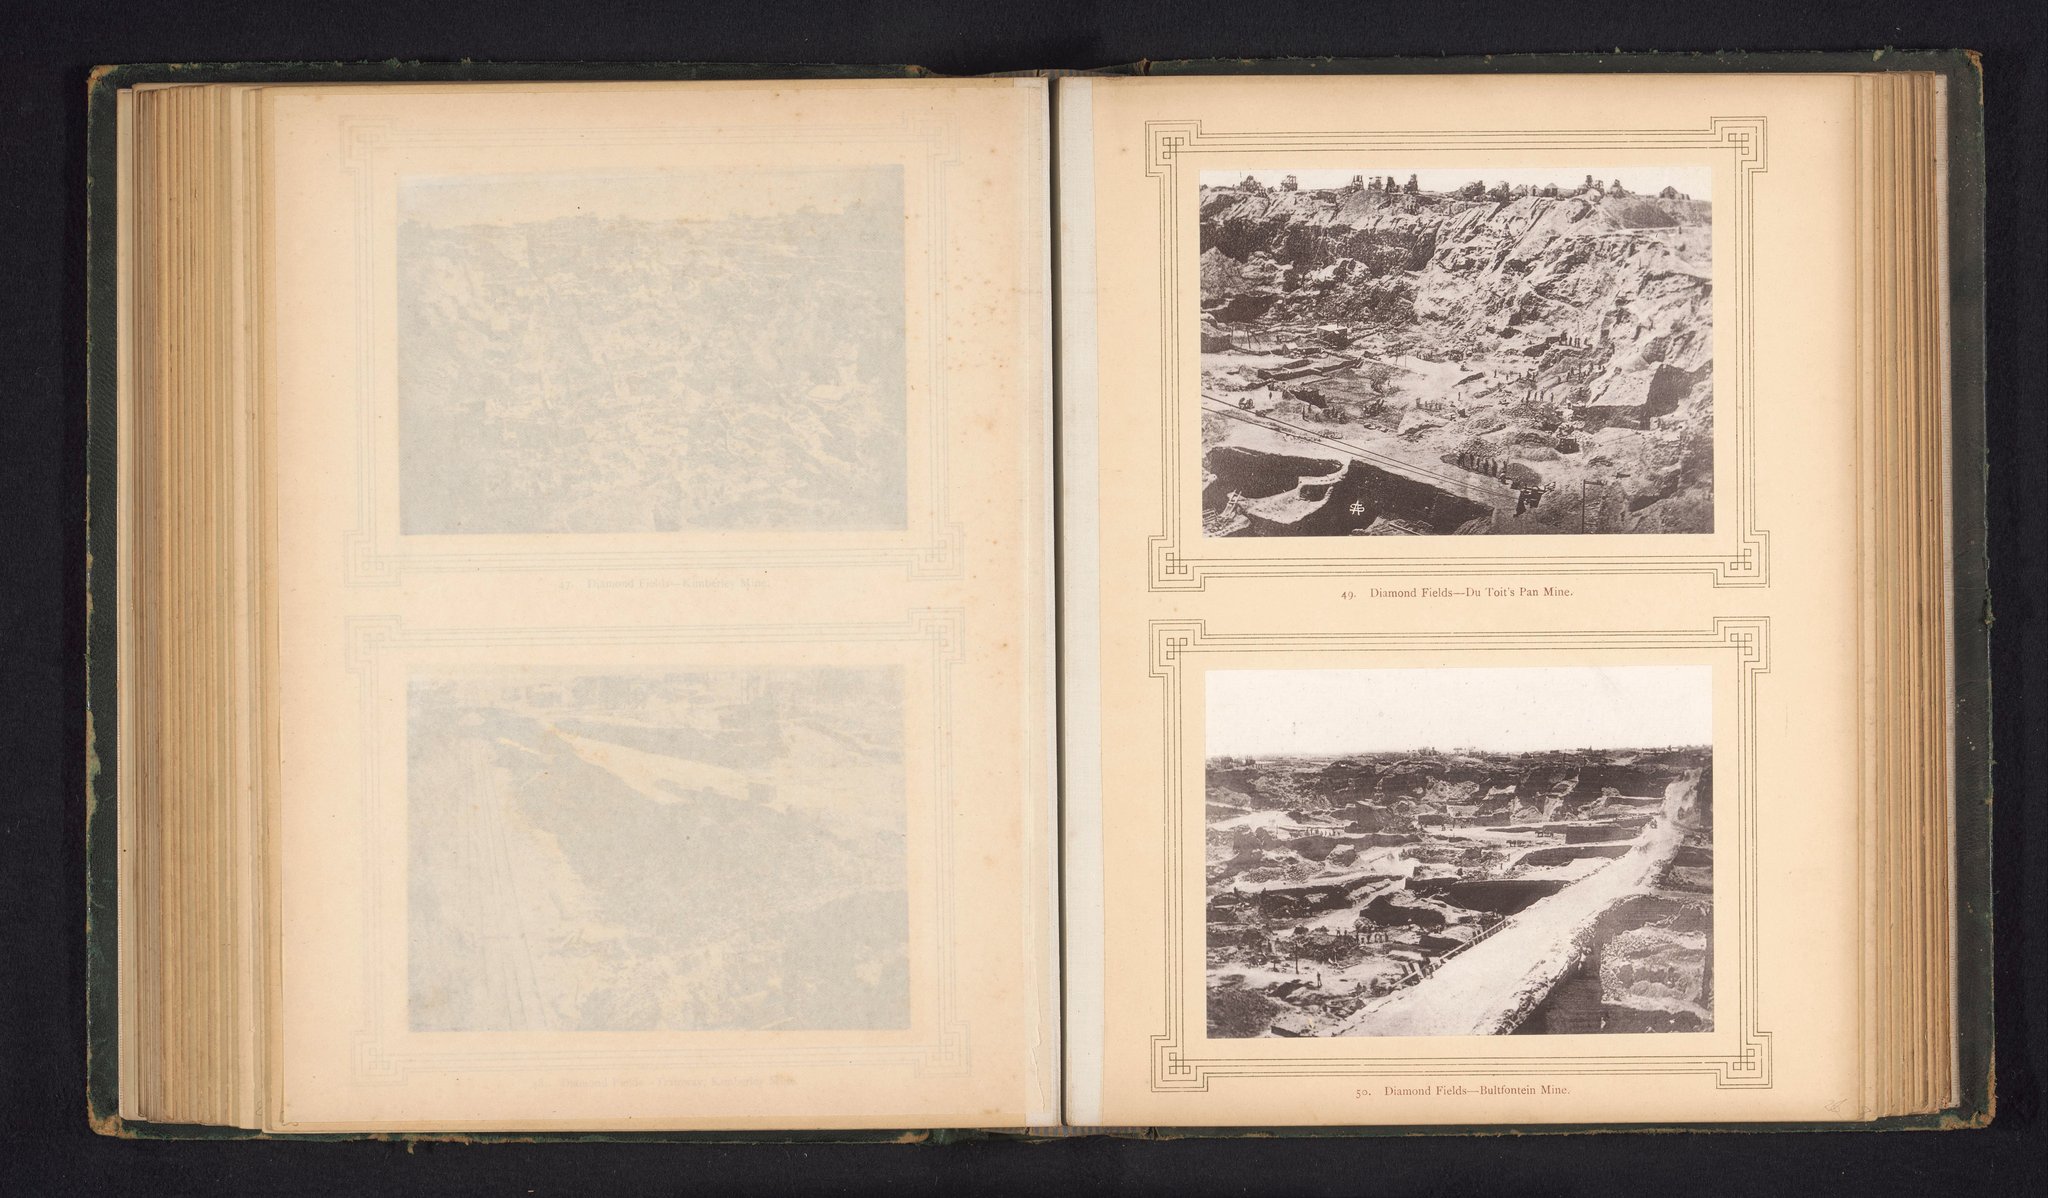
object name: page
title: Diamond fields-Du Toit's pan mine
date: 1870-1880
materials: paper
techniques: photograph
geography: south africa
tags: quarry, mine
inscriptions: number: ‘49. 50.’, inscription: ‘SA’